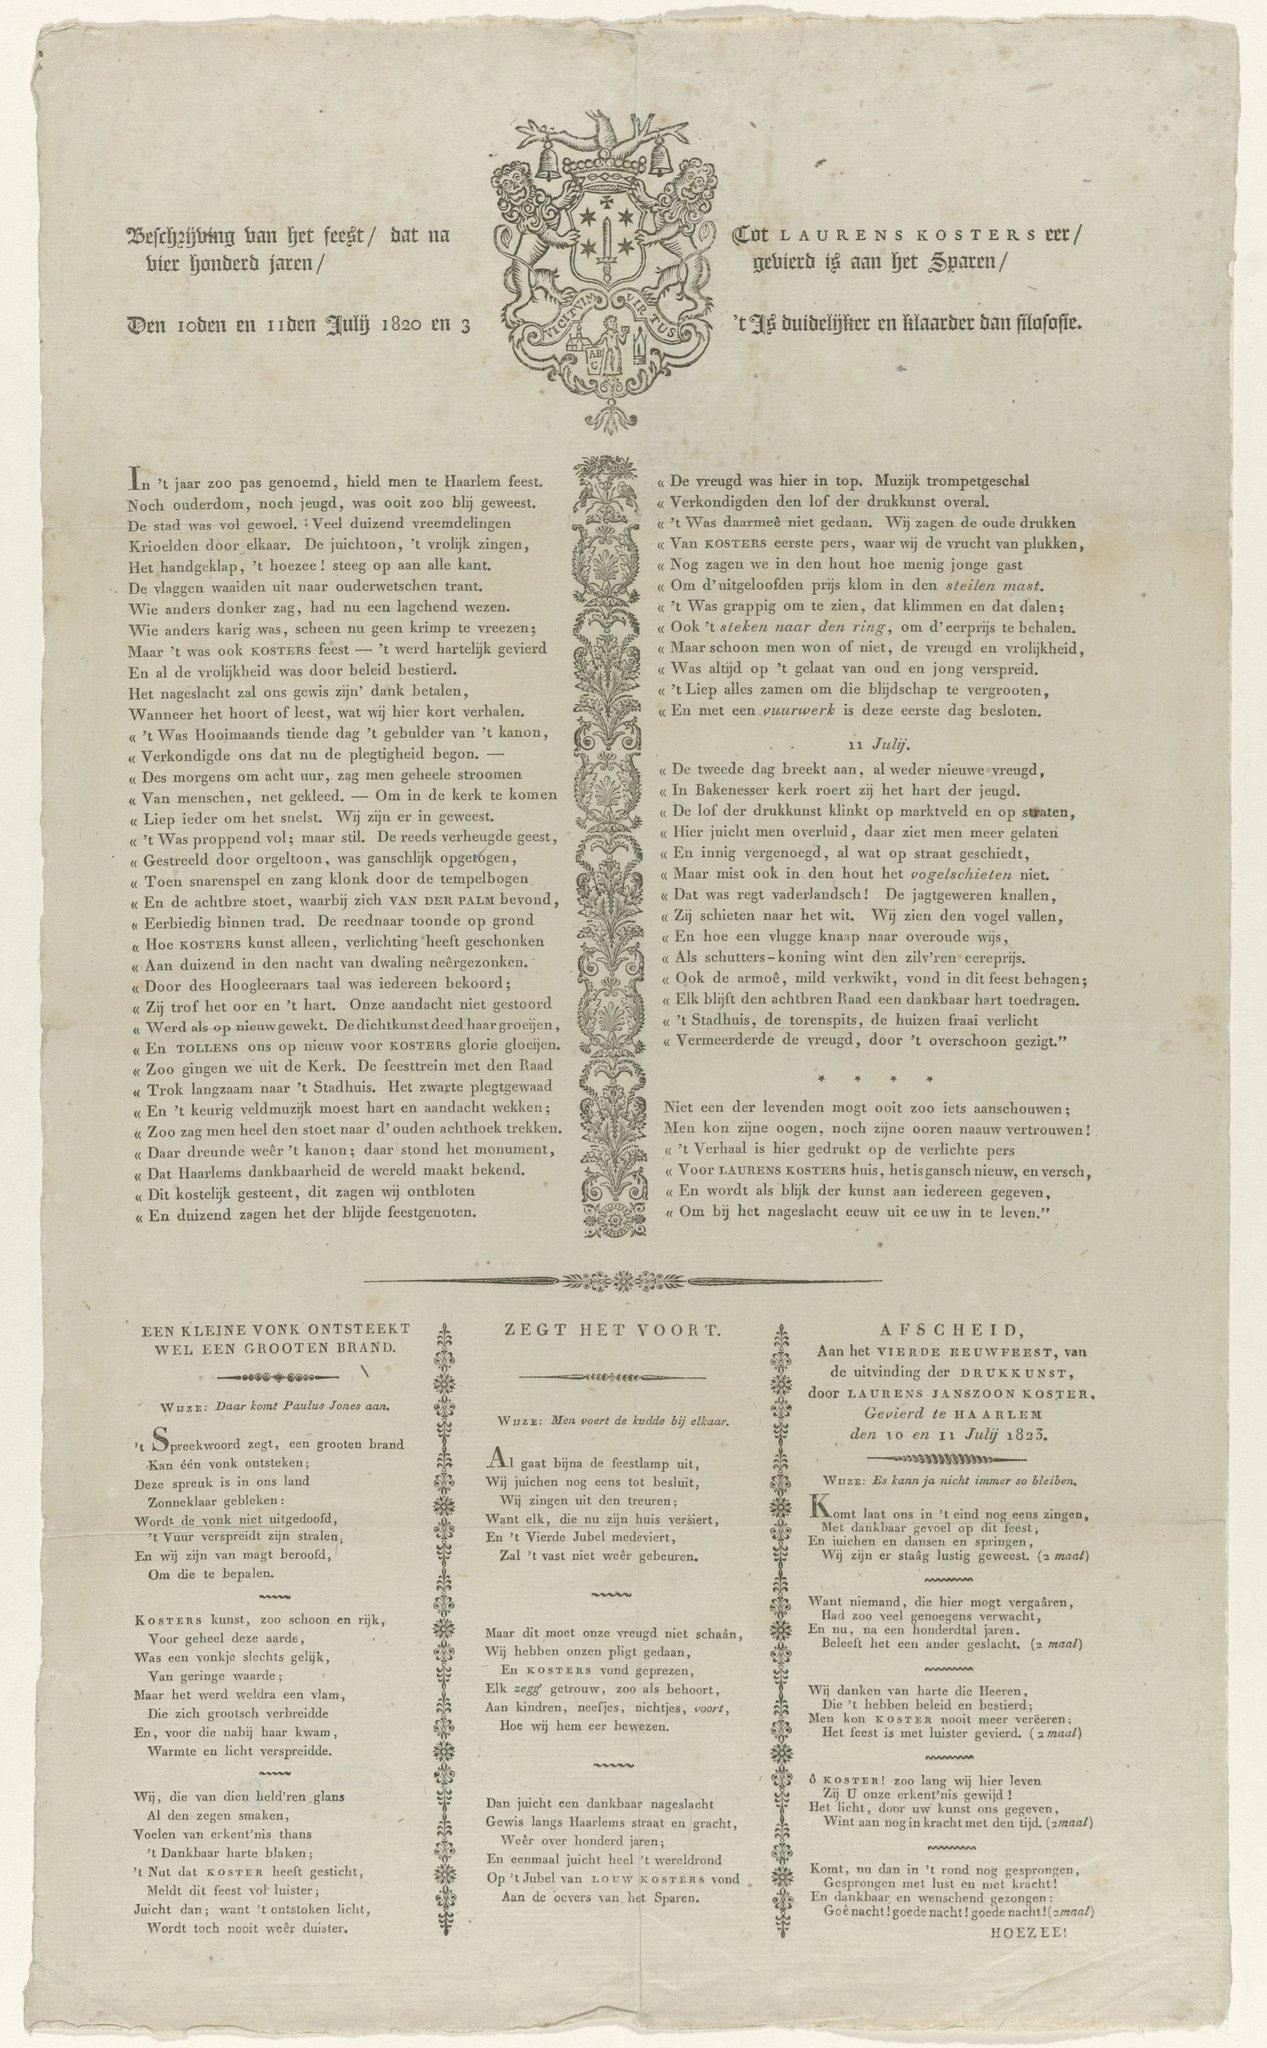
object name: text sheet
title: Beschrijving van het feest / dat na vier honderd jaren / tot Laurens Kosters eer / gevierd is aan het Sparen / Den 10den en 11den Julij 1820 en 3 / 't Is duidelijker en klaarder dan filosofie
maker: Anonymous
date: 1823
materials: paper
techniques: letterpress printing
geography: haarlem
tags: haarlem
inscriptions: collector's mark: Lugt 2228, collector's mark: Lugt 2760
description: Programma in versvorm van het 400-jarig jubileum van de uitvinding van de boekdrukkunst door Coster, 10 en 11 juli 1823 te Haarlem. Gedicht in twee kolommen waarin de festiviteiten gepland voor 10 en 11 juli in versvorm worden beschreven. Onderaan drie afzonderlijke verzen. Bovenaan het wapen van Haarlem.